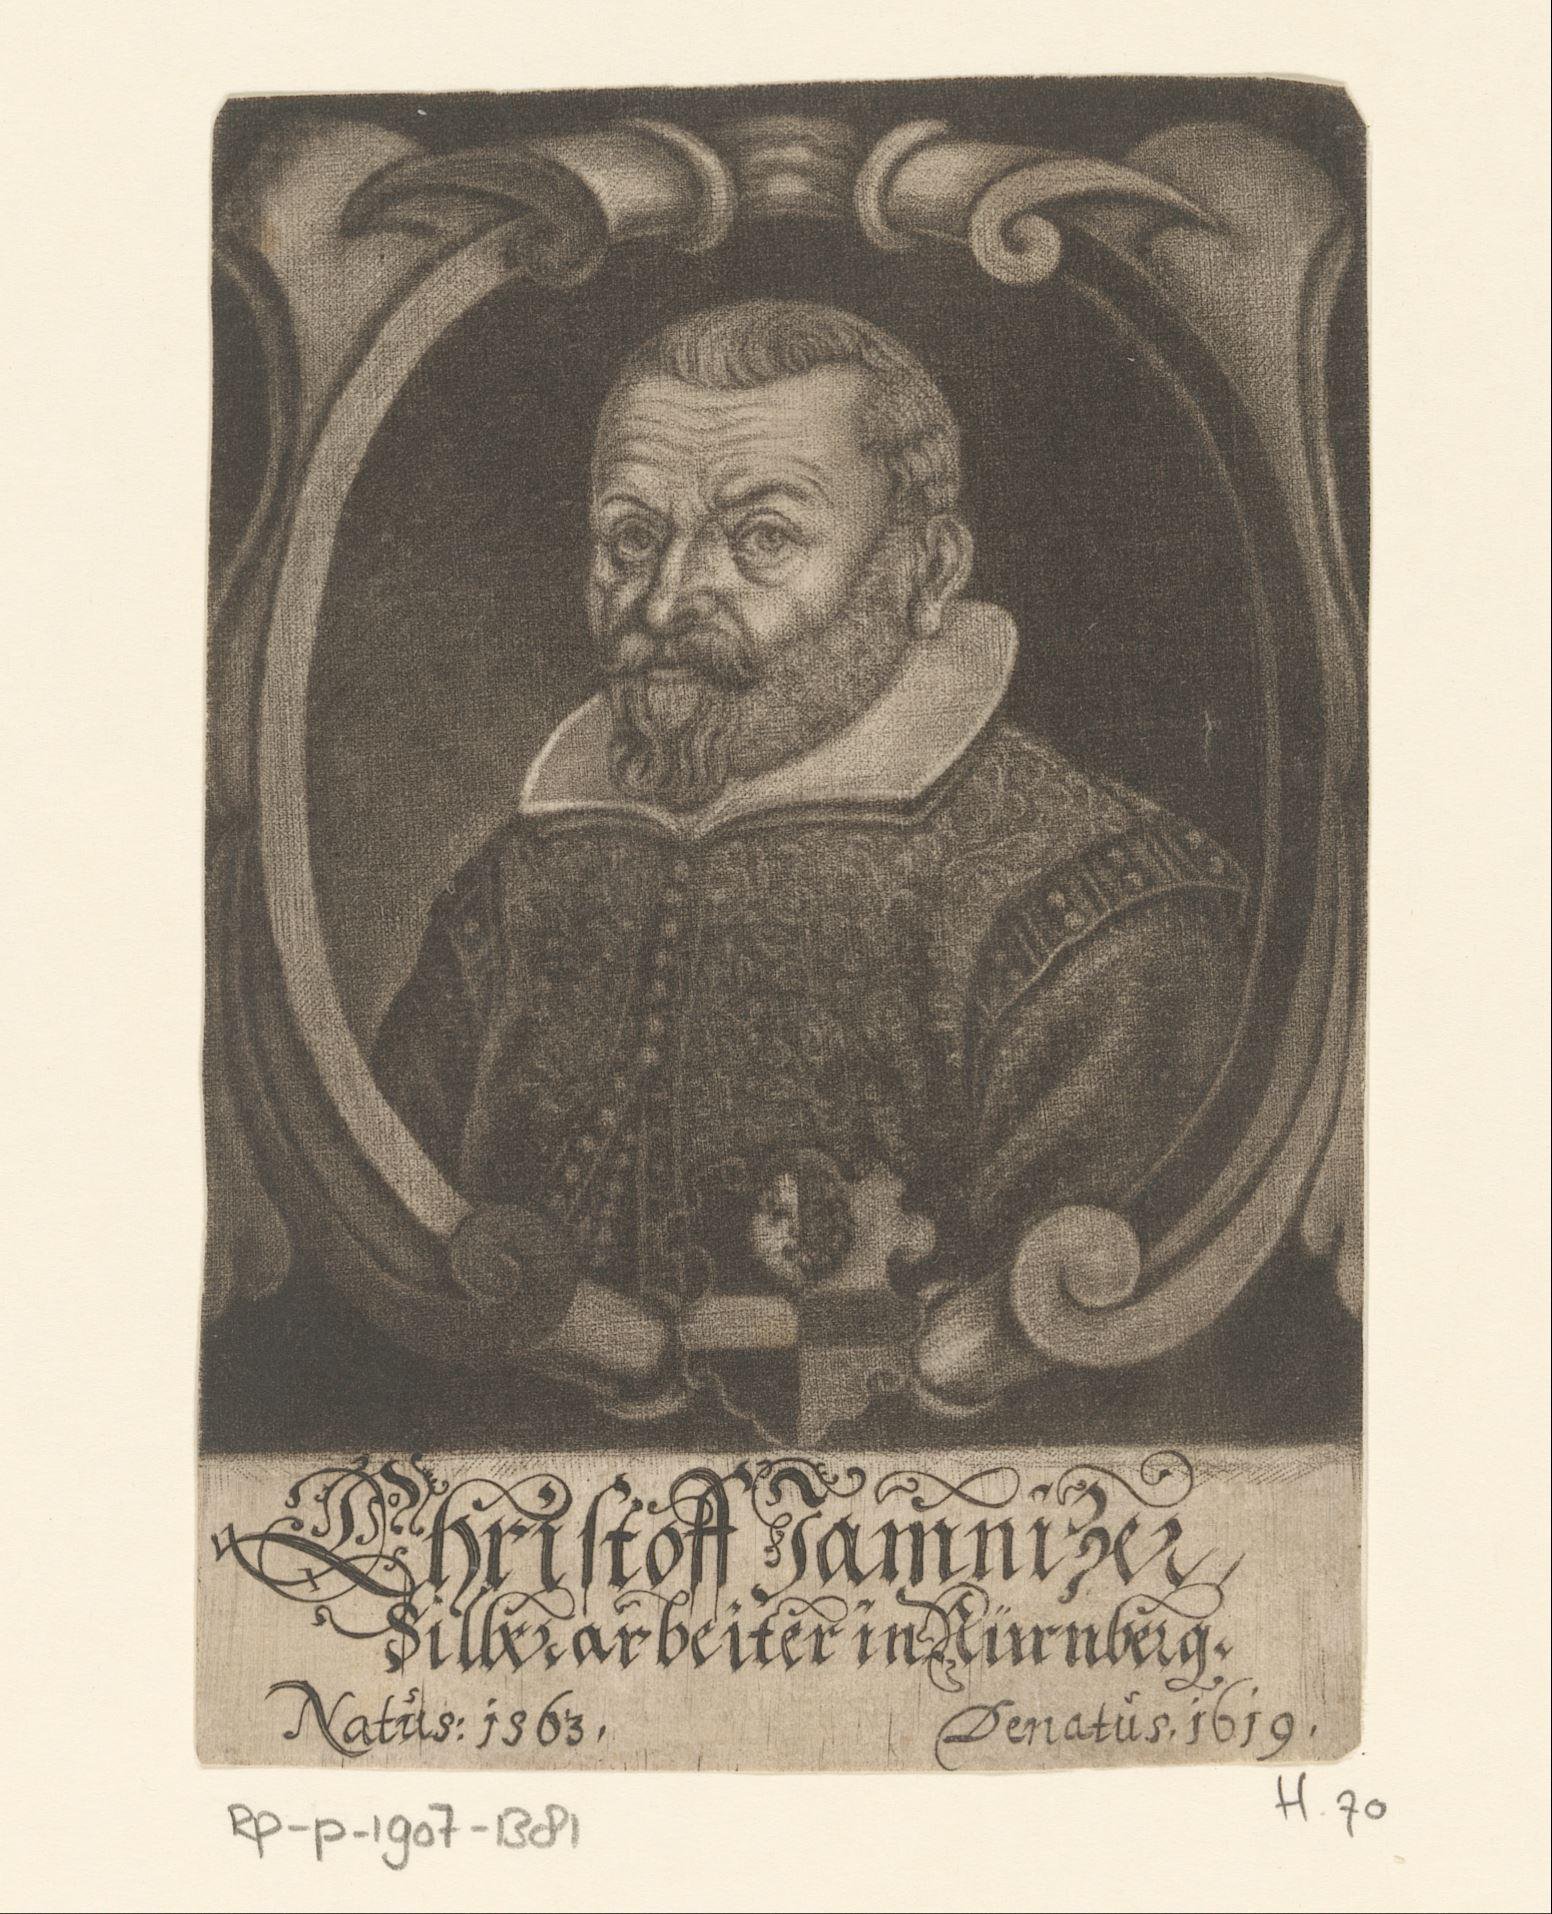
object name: print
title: Portret van Christoph Jamnitzer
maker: georg fennitzer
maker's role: print maker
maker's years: 1646-1722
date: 1656-1722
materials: paper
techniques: mezzotint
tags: goldsmith, historical persons, ornament ~ cartouche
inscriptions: collector's mark: Lugt 2228